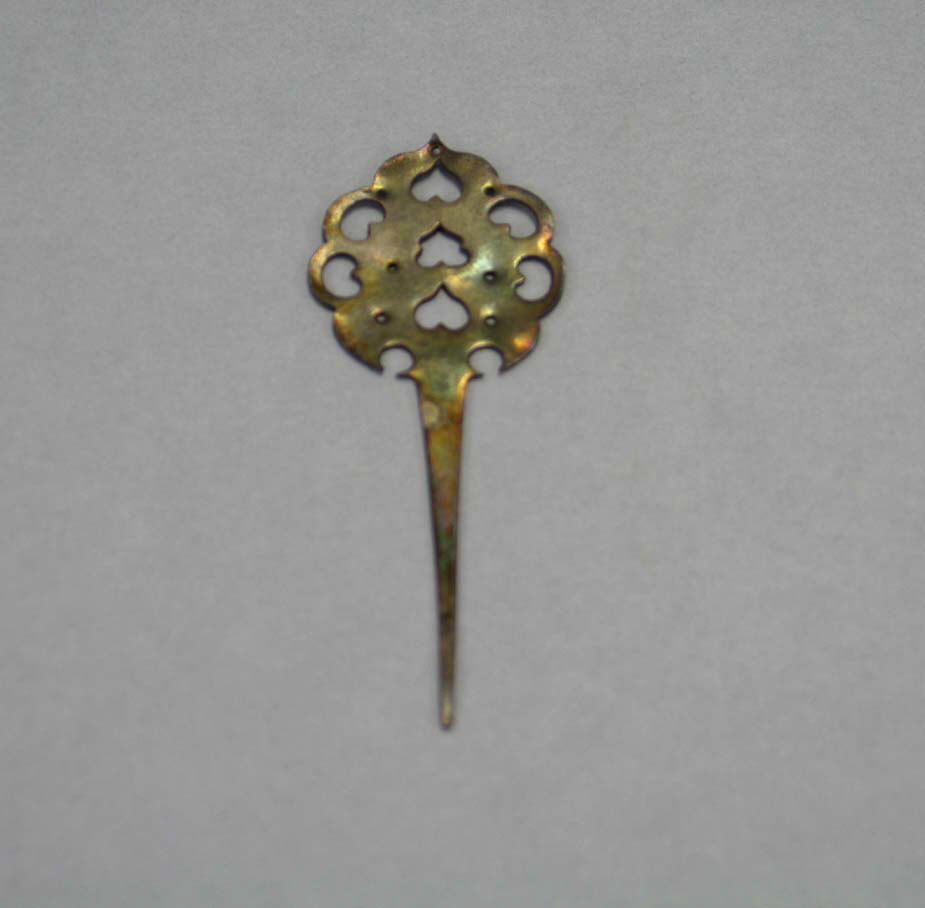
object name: fragment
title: Ornament (fragment)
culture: chinese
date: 618-907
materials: silver